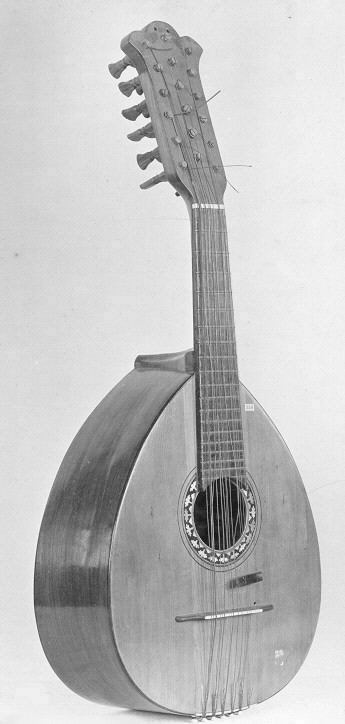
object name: bandolin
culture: mexican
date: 1867-1900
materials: metal, wood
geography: mexico